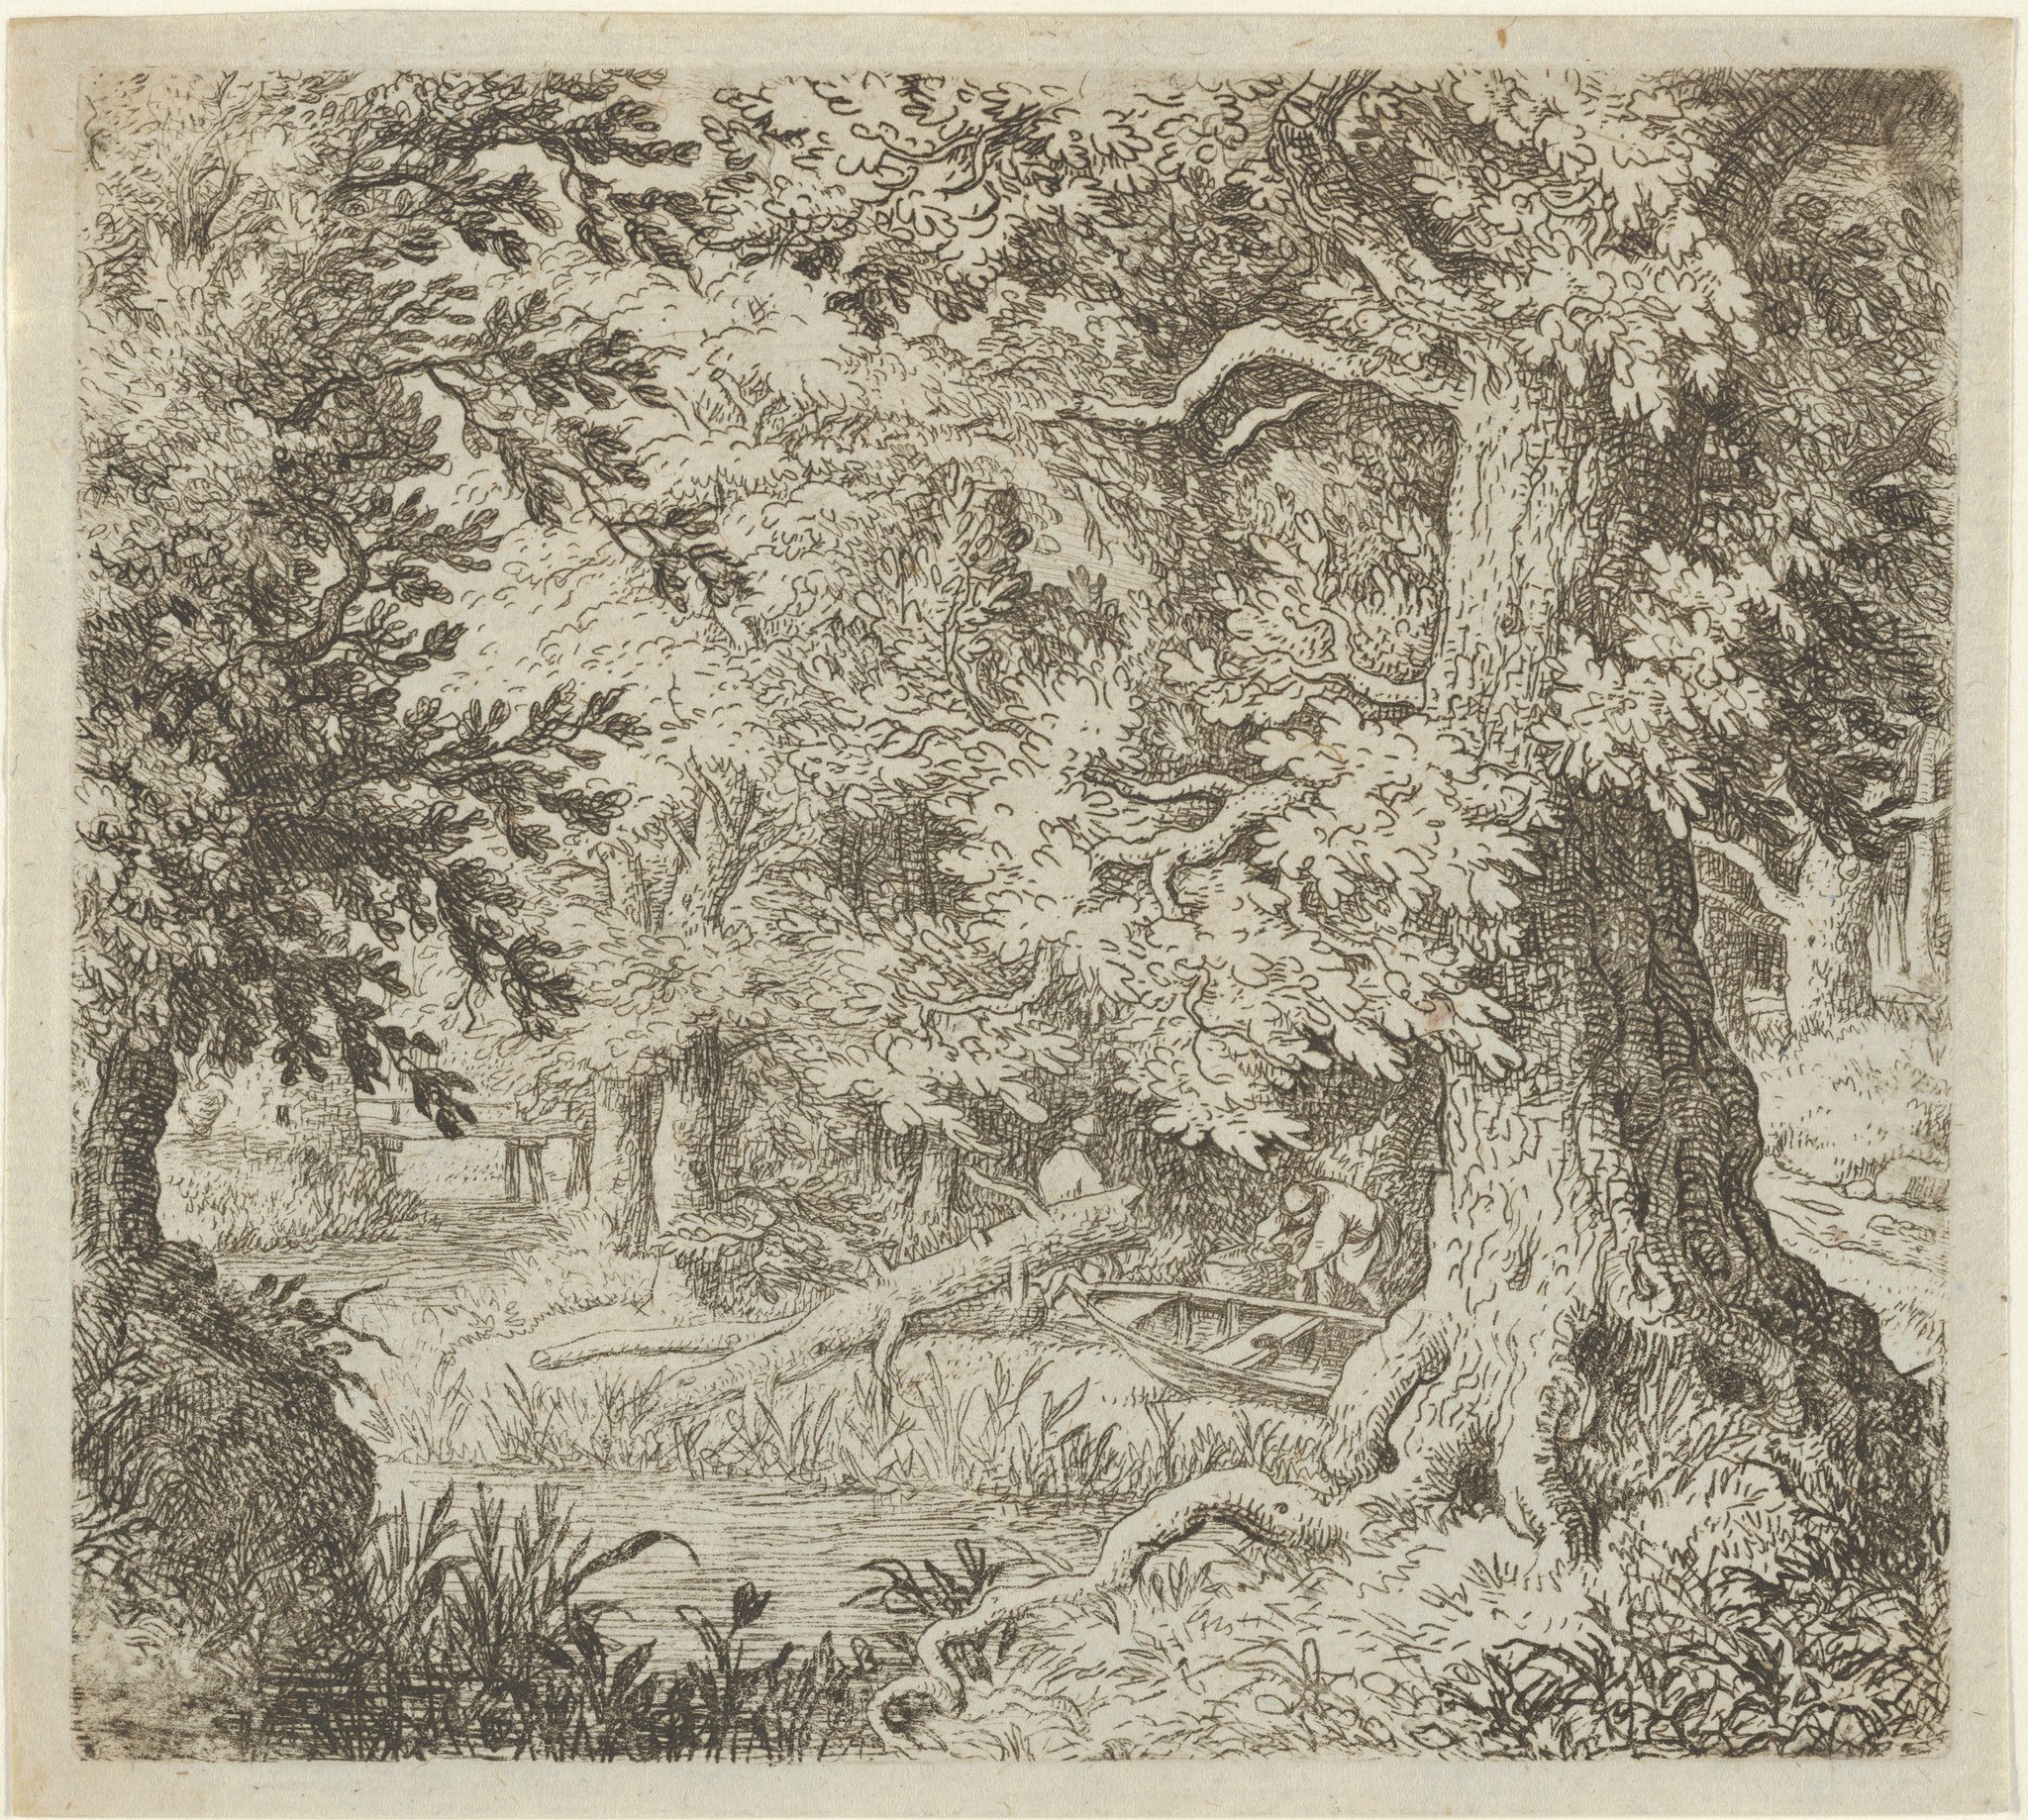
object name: print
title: The Brook in the Wood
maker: allart van everdingen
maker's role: artist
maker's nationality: dutch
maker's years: 1621-1675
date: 1621-1675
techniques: engraving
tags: forests,boats